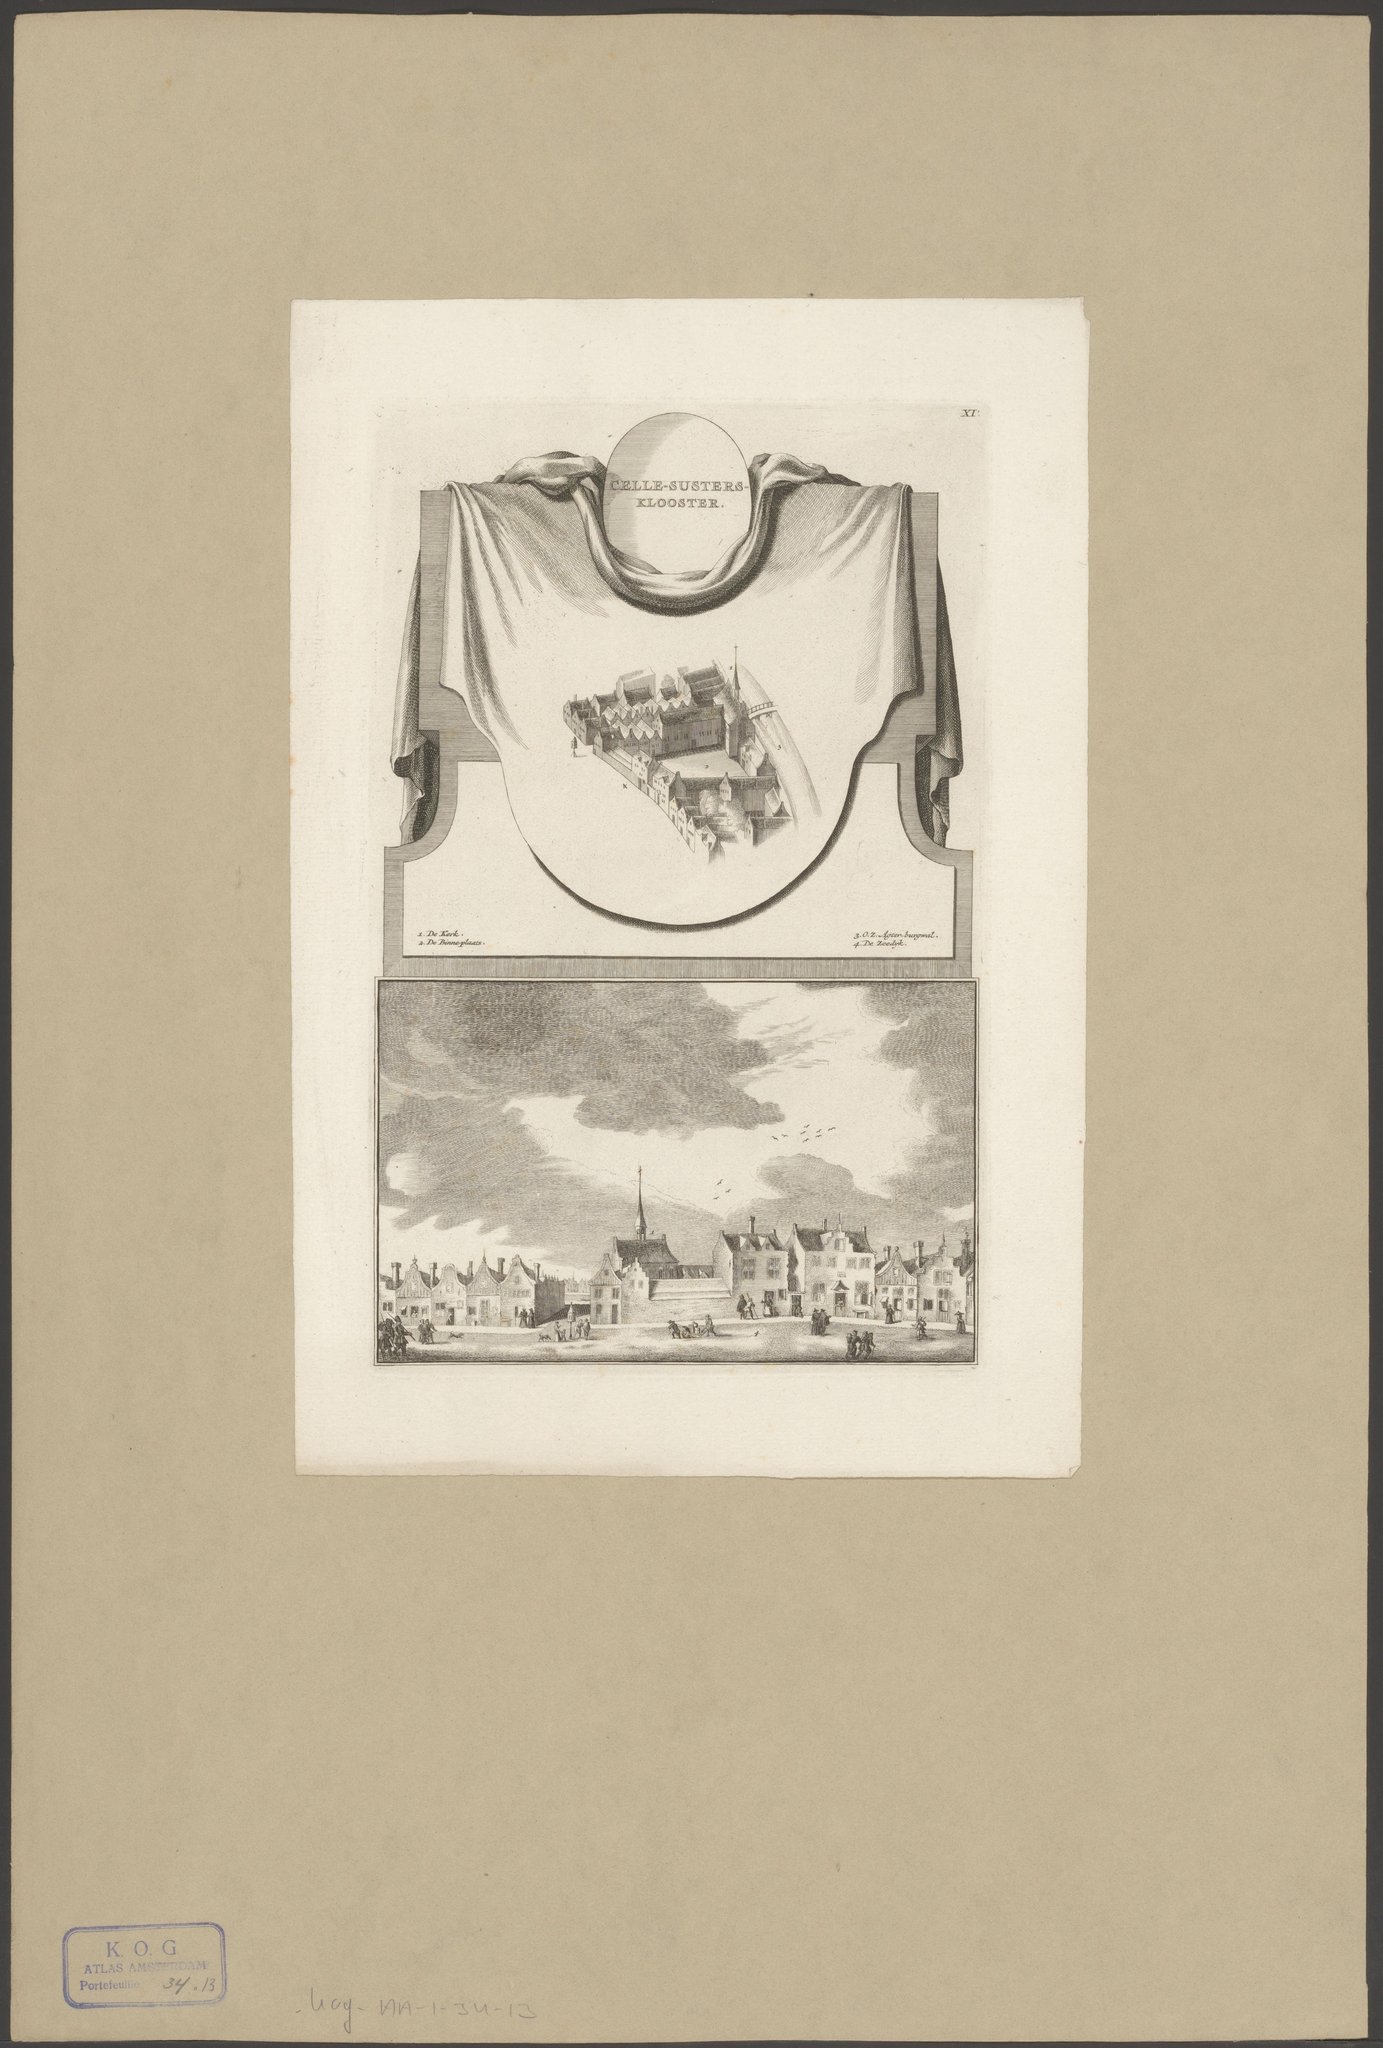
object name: print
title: Celle-Susters-Klooster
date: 1760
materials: paper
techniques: engraving, etching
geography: amsterdam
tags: abbey, monastery, convent ~ roman catholic church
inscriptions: collector's mark: Lugt 1641b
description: Prent mogelijk uit: Wagenaar, Jan. Amsterdam, in zyne opkomst, aanwas, geschiedenissen (…). Amsterdam: Isaak Tirion, 1760, dl. 1. Dat de prent de situatie rond 1544 weergeeft, gaat terug op het feit dat voor het maken van deze en andere prenten van kloosters en kerken van voor de Alteratie (1578) is uitgegaan van de plattegrond van Cornelis Anthonisz. uit 1544, zie RP-P-OB-70.399 en RP-P-AO-20-15.